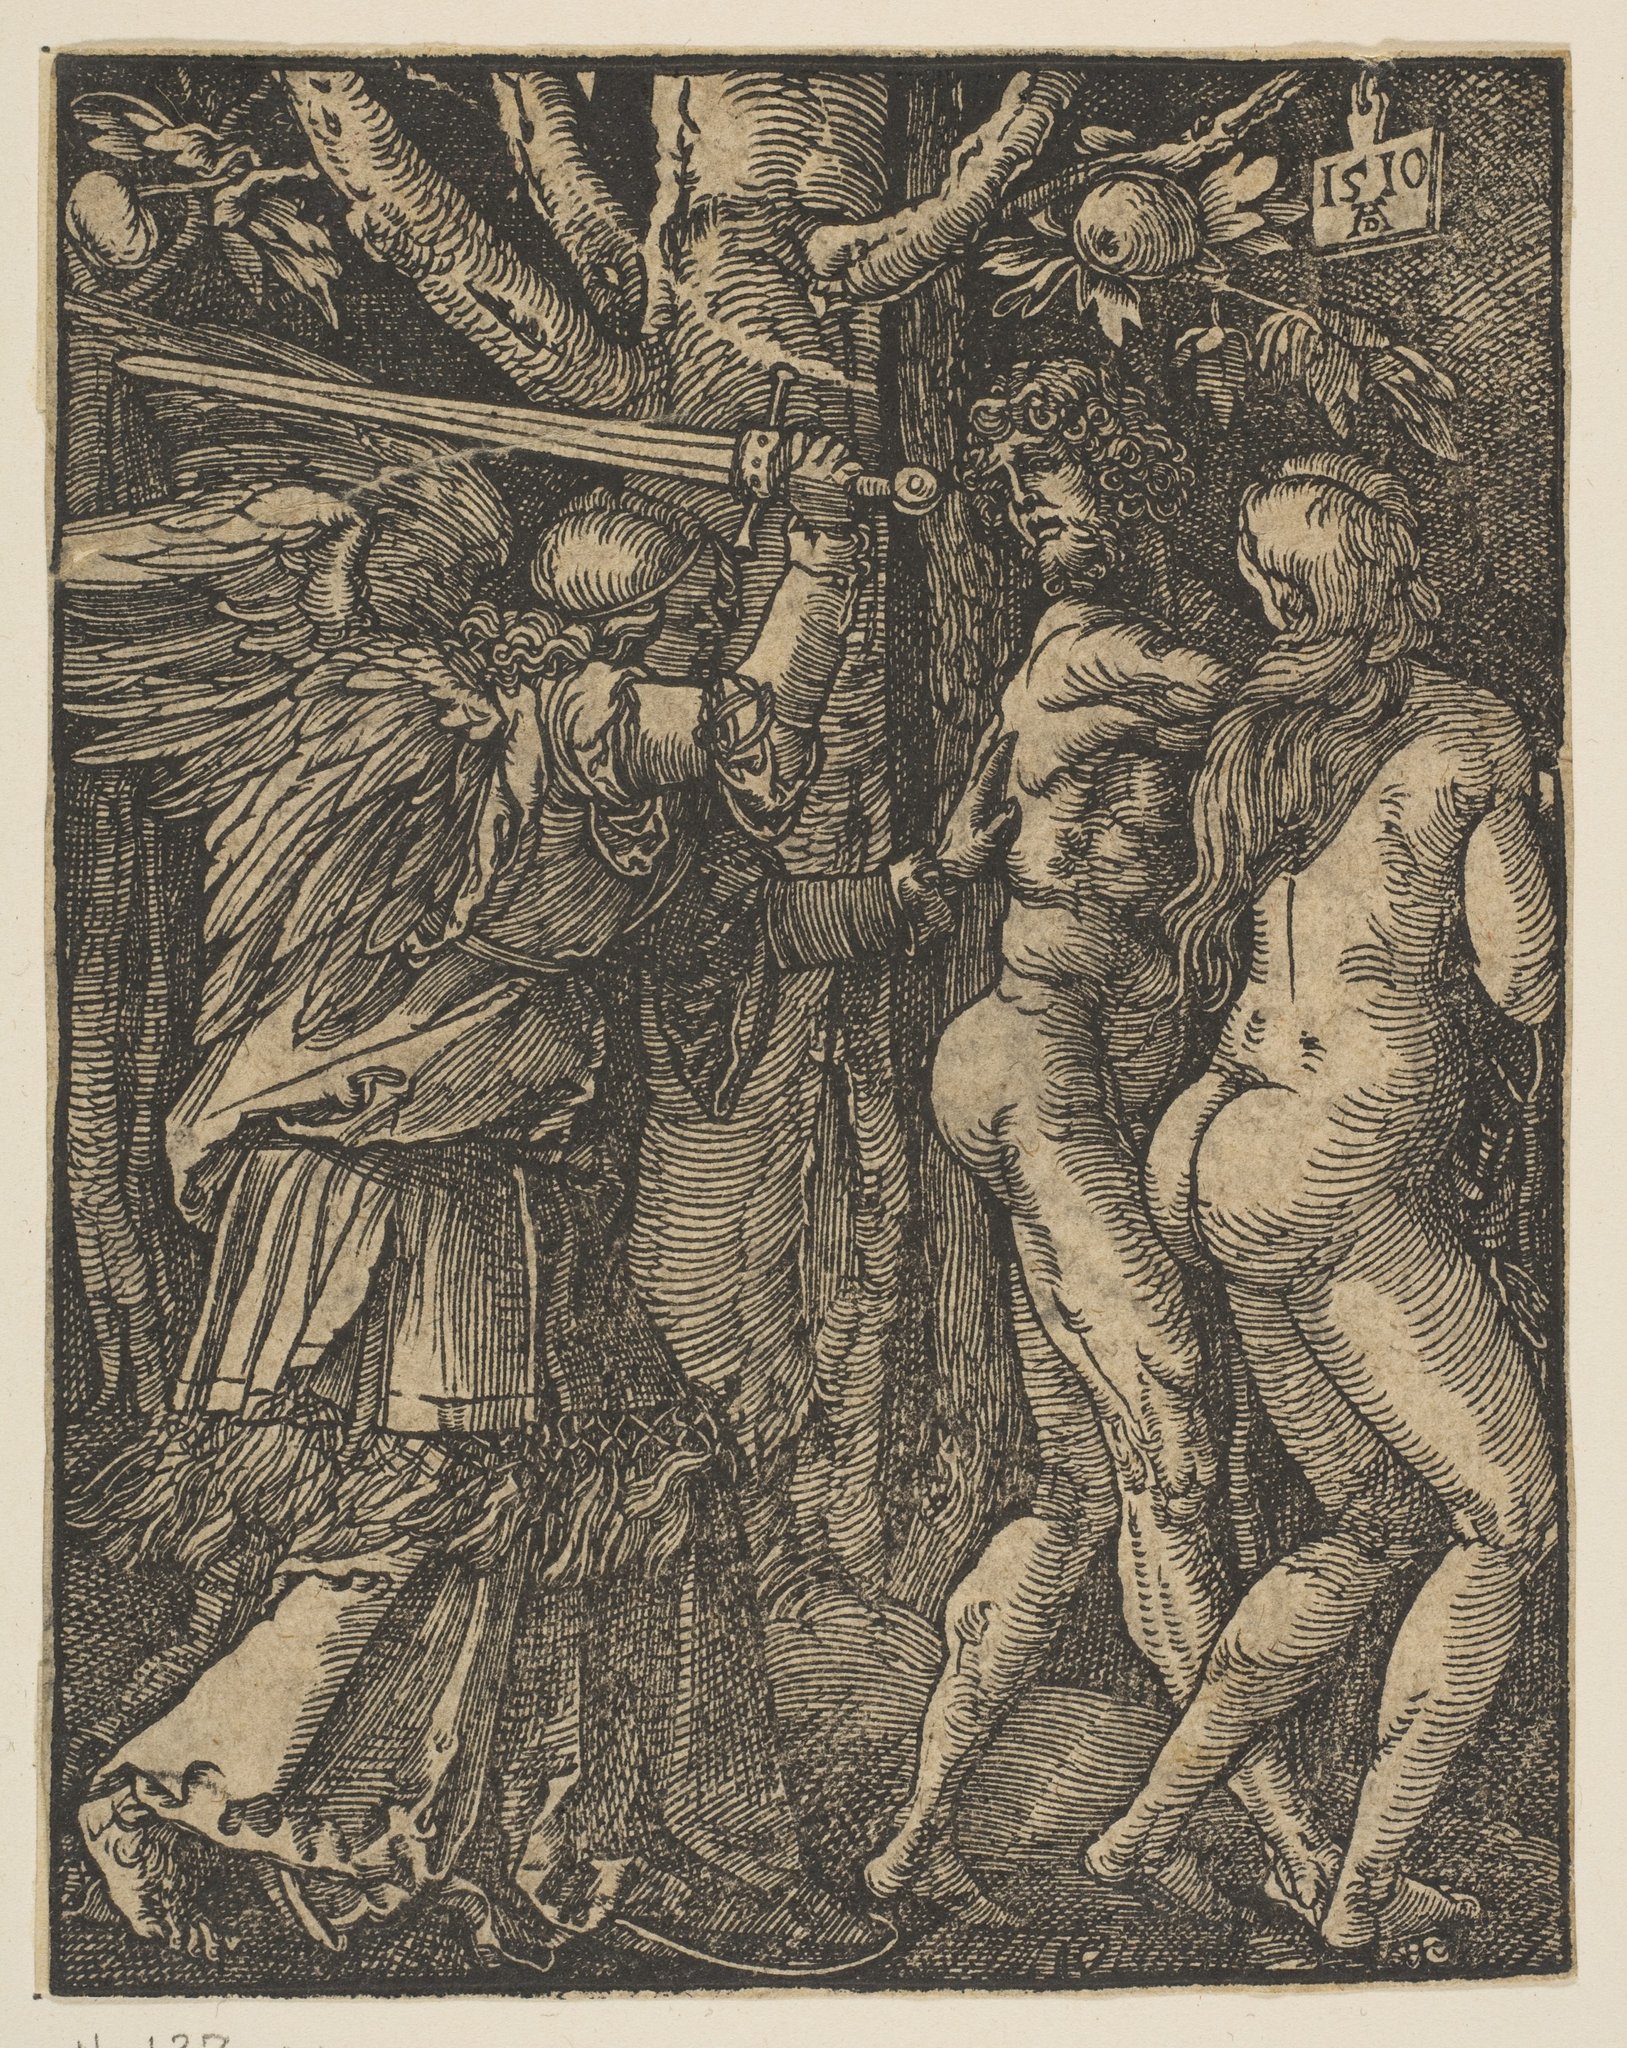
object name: print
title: Expulsion from Paradise, from "The Small Passion" (copy)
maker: albrecht dürer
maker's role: artist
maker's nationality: german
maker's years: 1471-1528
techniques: woodcut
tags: male nudes,female nudes,adam,eve